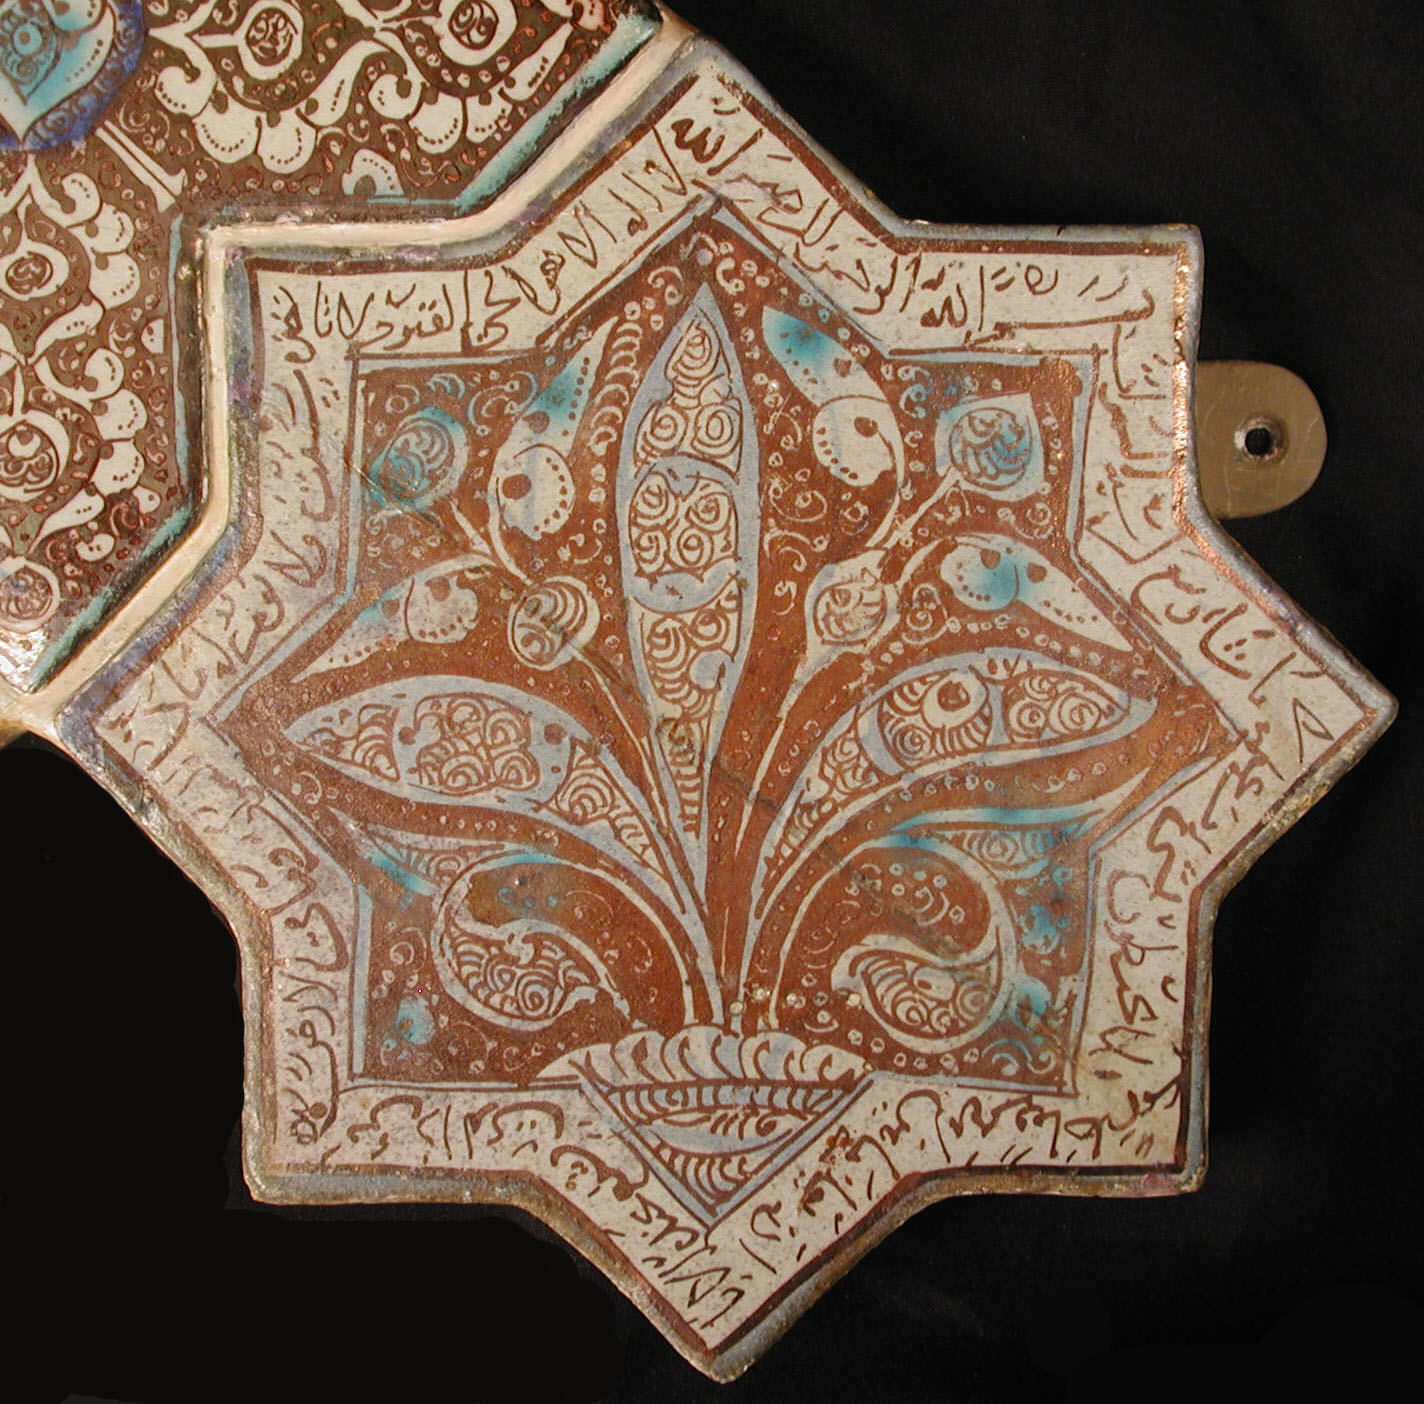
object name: tile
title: Star-Shaped Tile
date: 1201-1400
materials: glaze, stonepaste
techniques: luster painting, painting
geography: iran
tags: plants